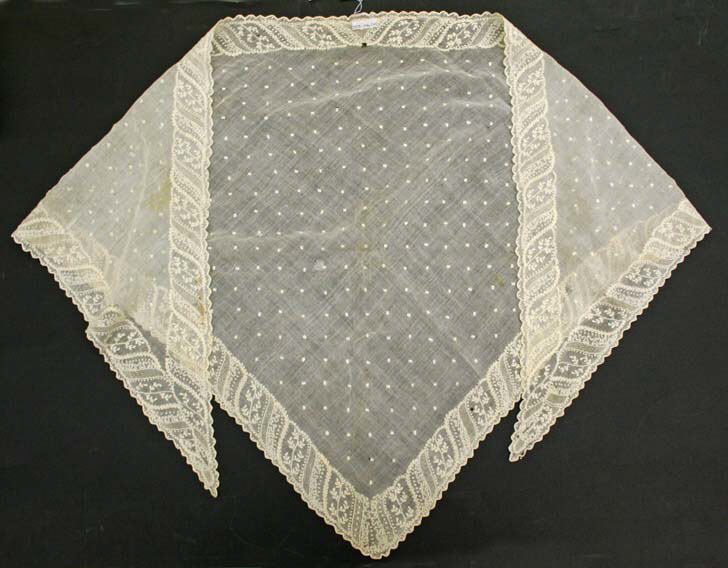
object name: fichu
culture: american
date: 1776-1800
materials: cotton